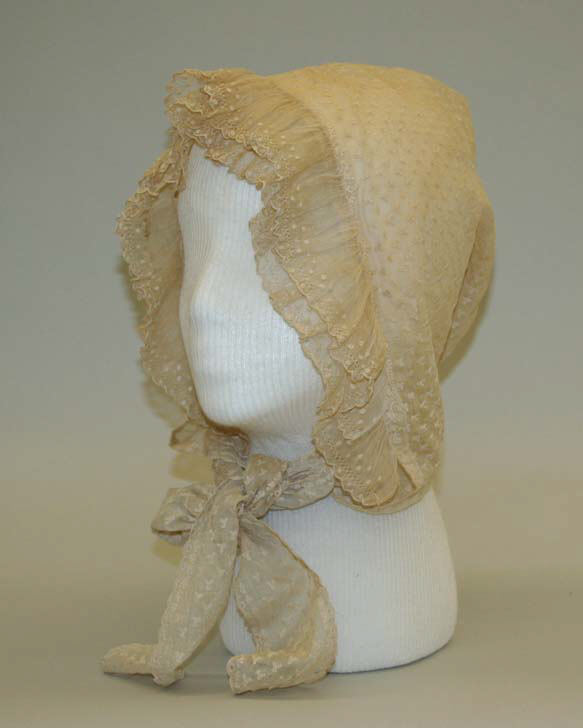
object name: cap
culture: american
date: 1750-1799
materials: cotton